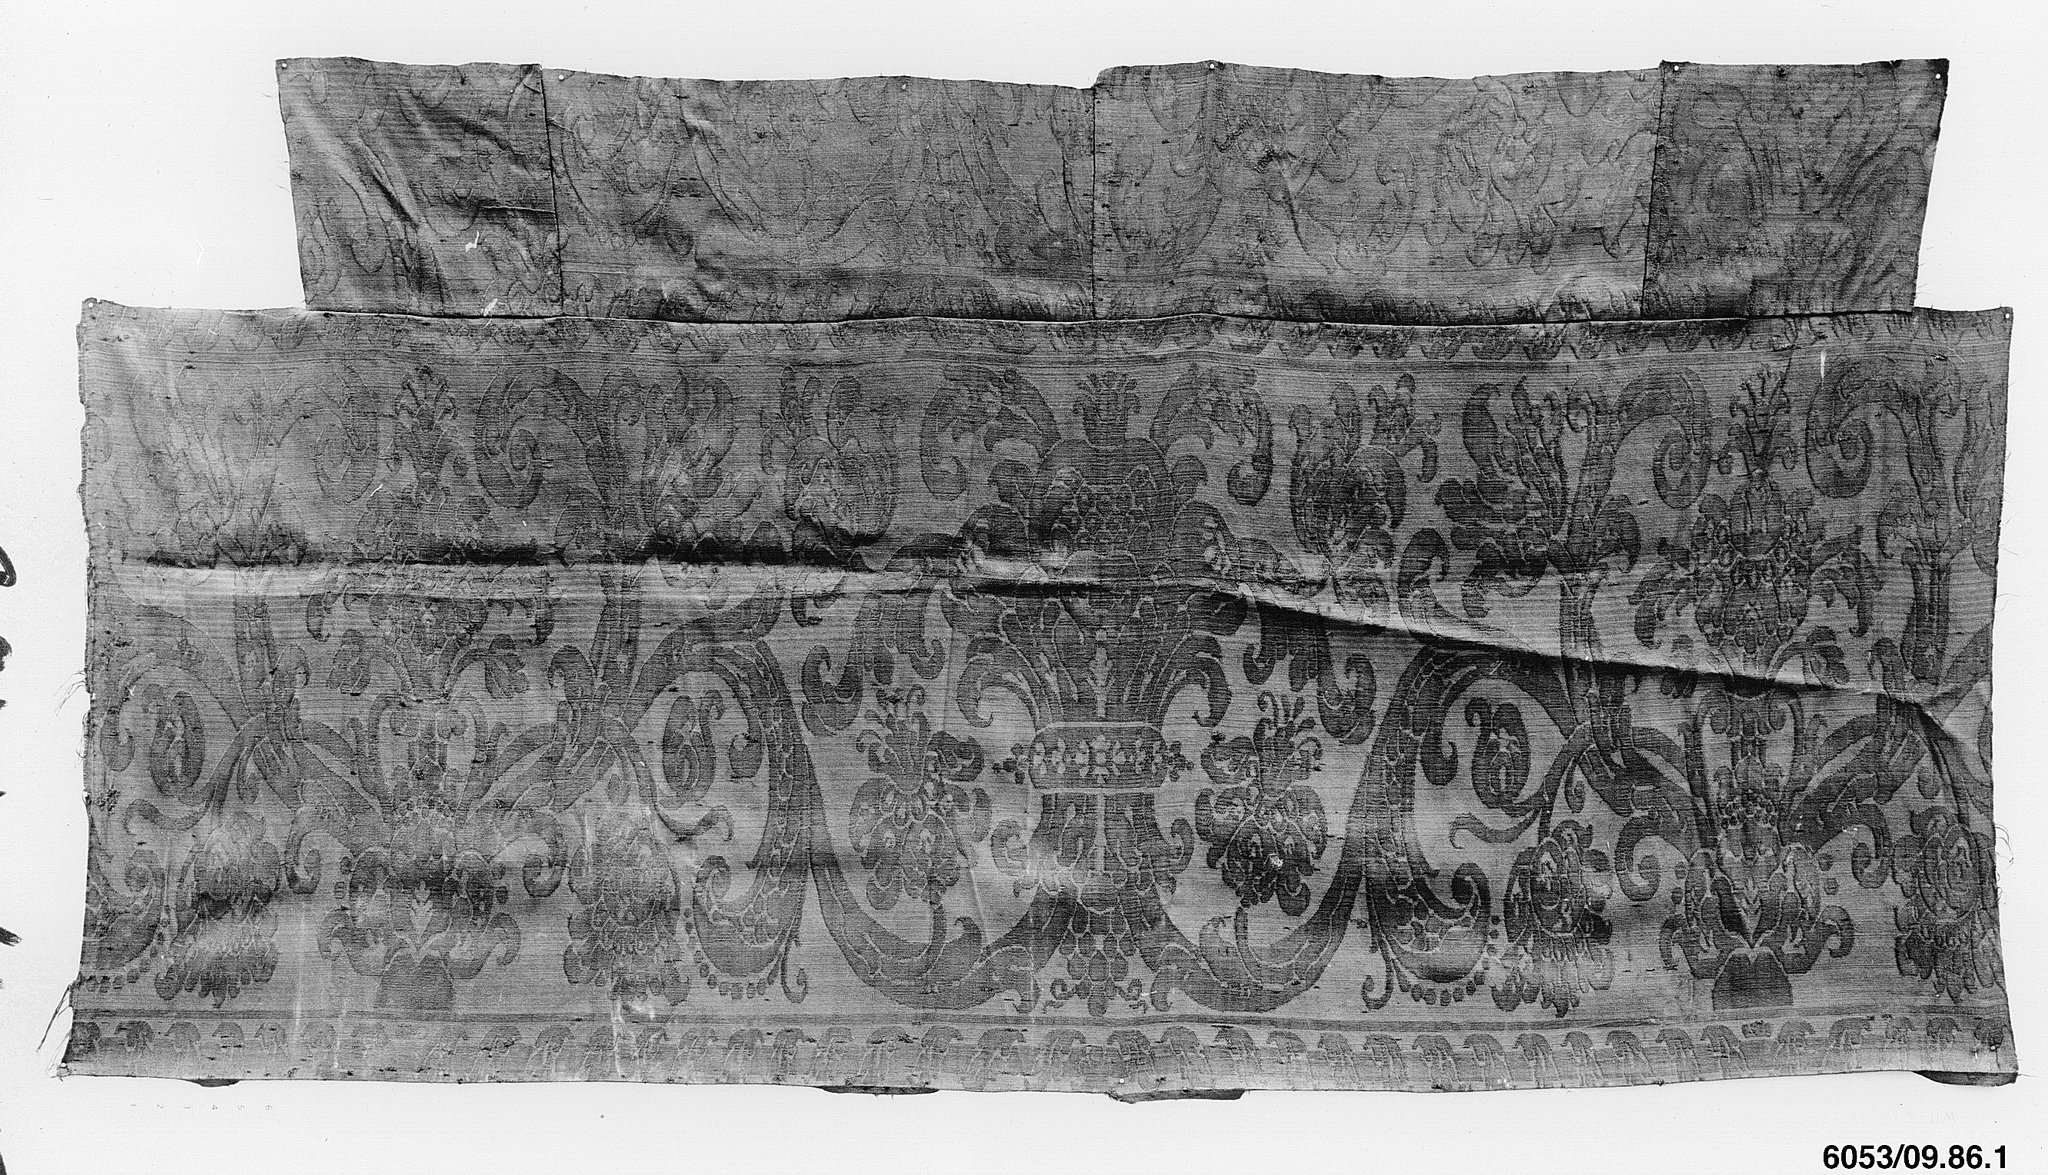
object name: piece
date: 1601-1700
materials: silk